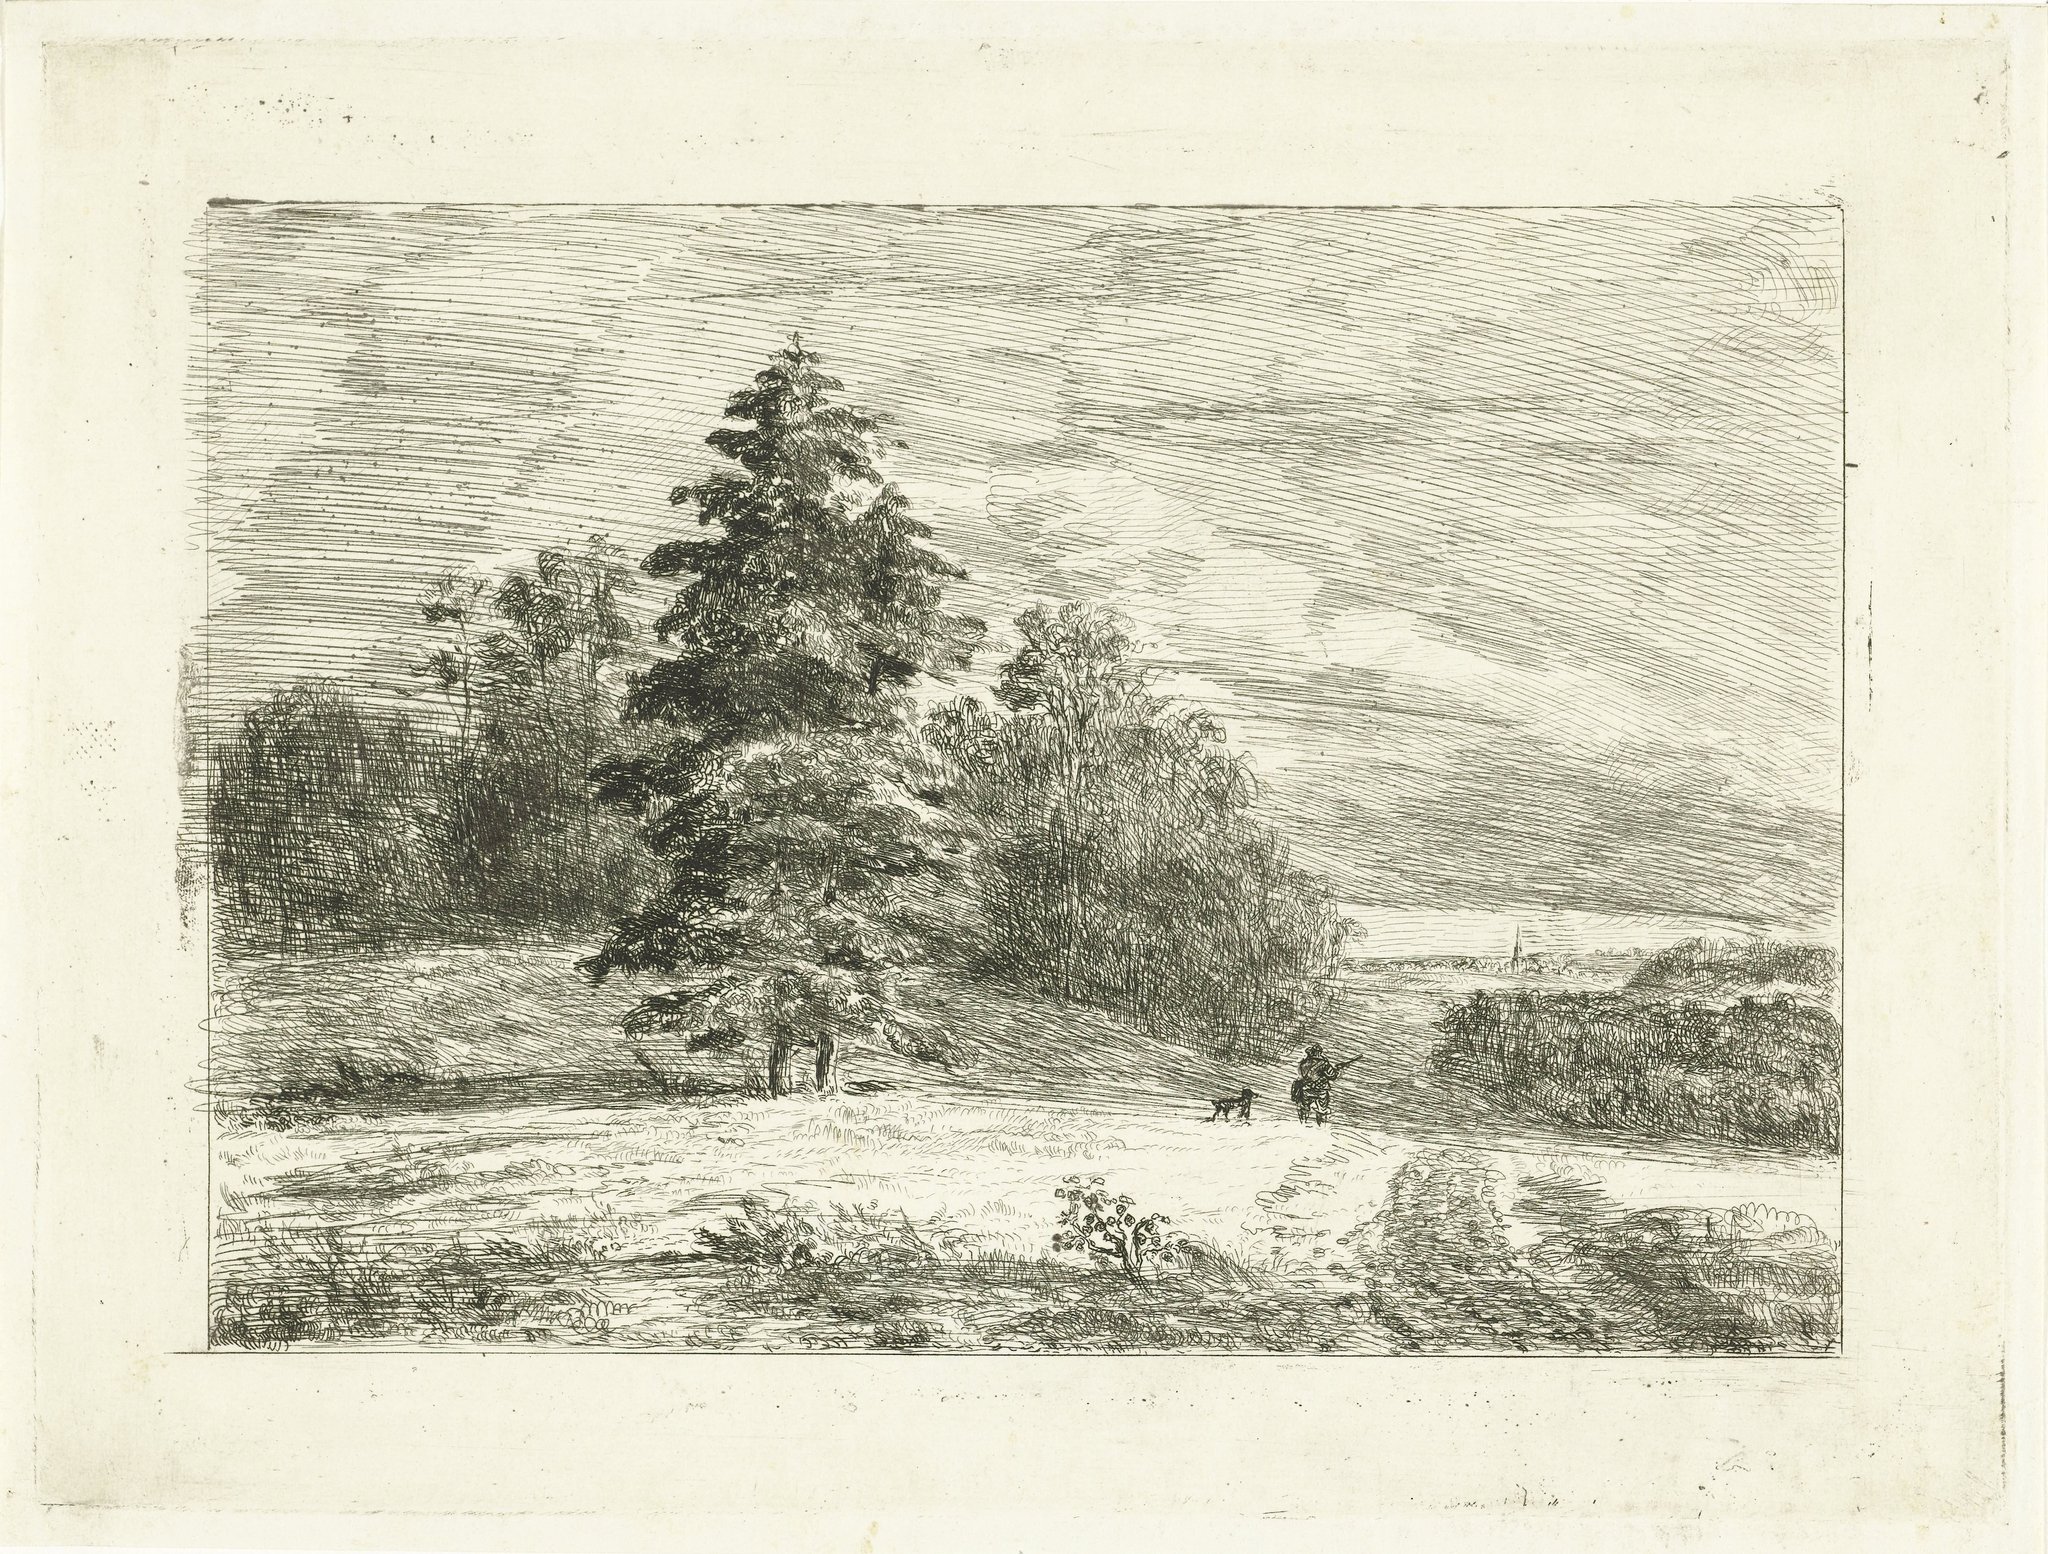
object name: print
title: Landschap met een jager met hond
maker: johannes adrianus van der drift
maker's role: print maker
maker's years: 1808-1883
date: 1823-1883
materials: paper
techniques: etching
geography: netherlands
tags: hunter, landscapes in the temperate zone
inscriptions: collector's mark: Lugt 2228